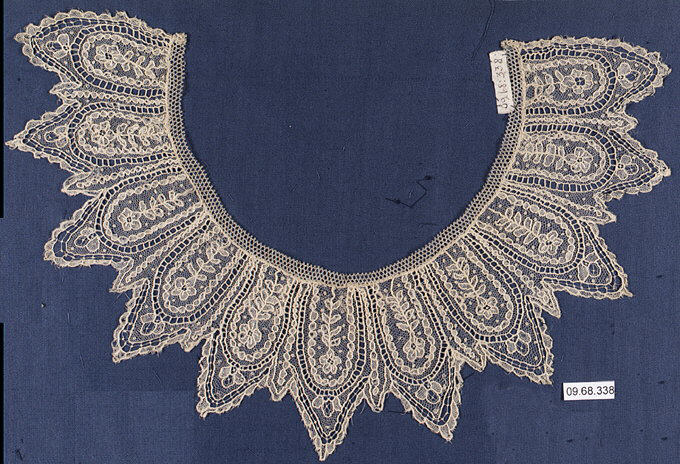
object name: collar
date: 1801-1900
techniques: lace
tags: flowers